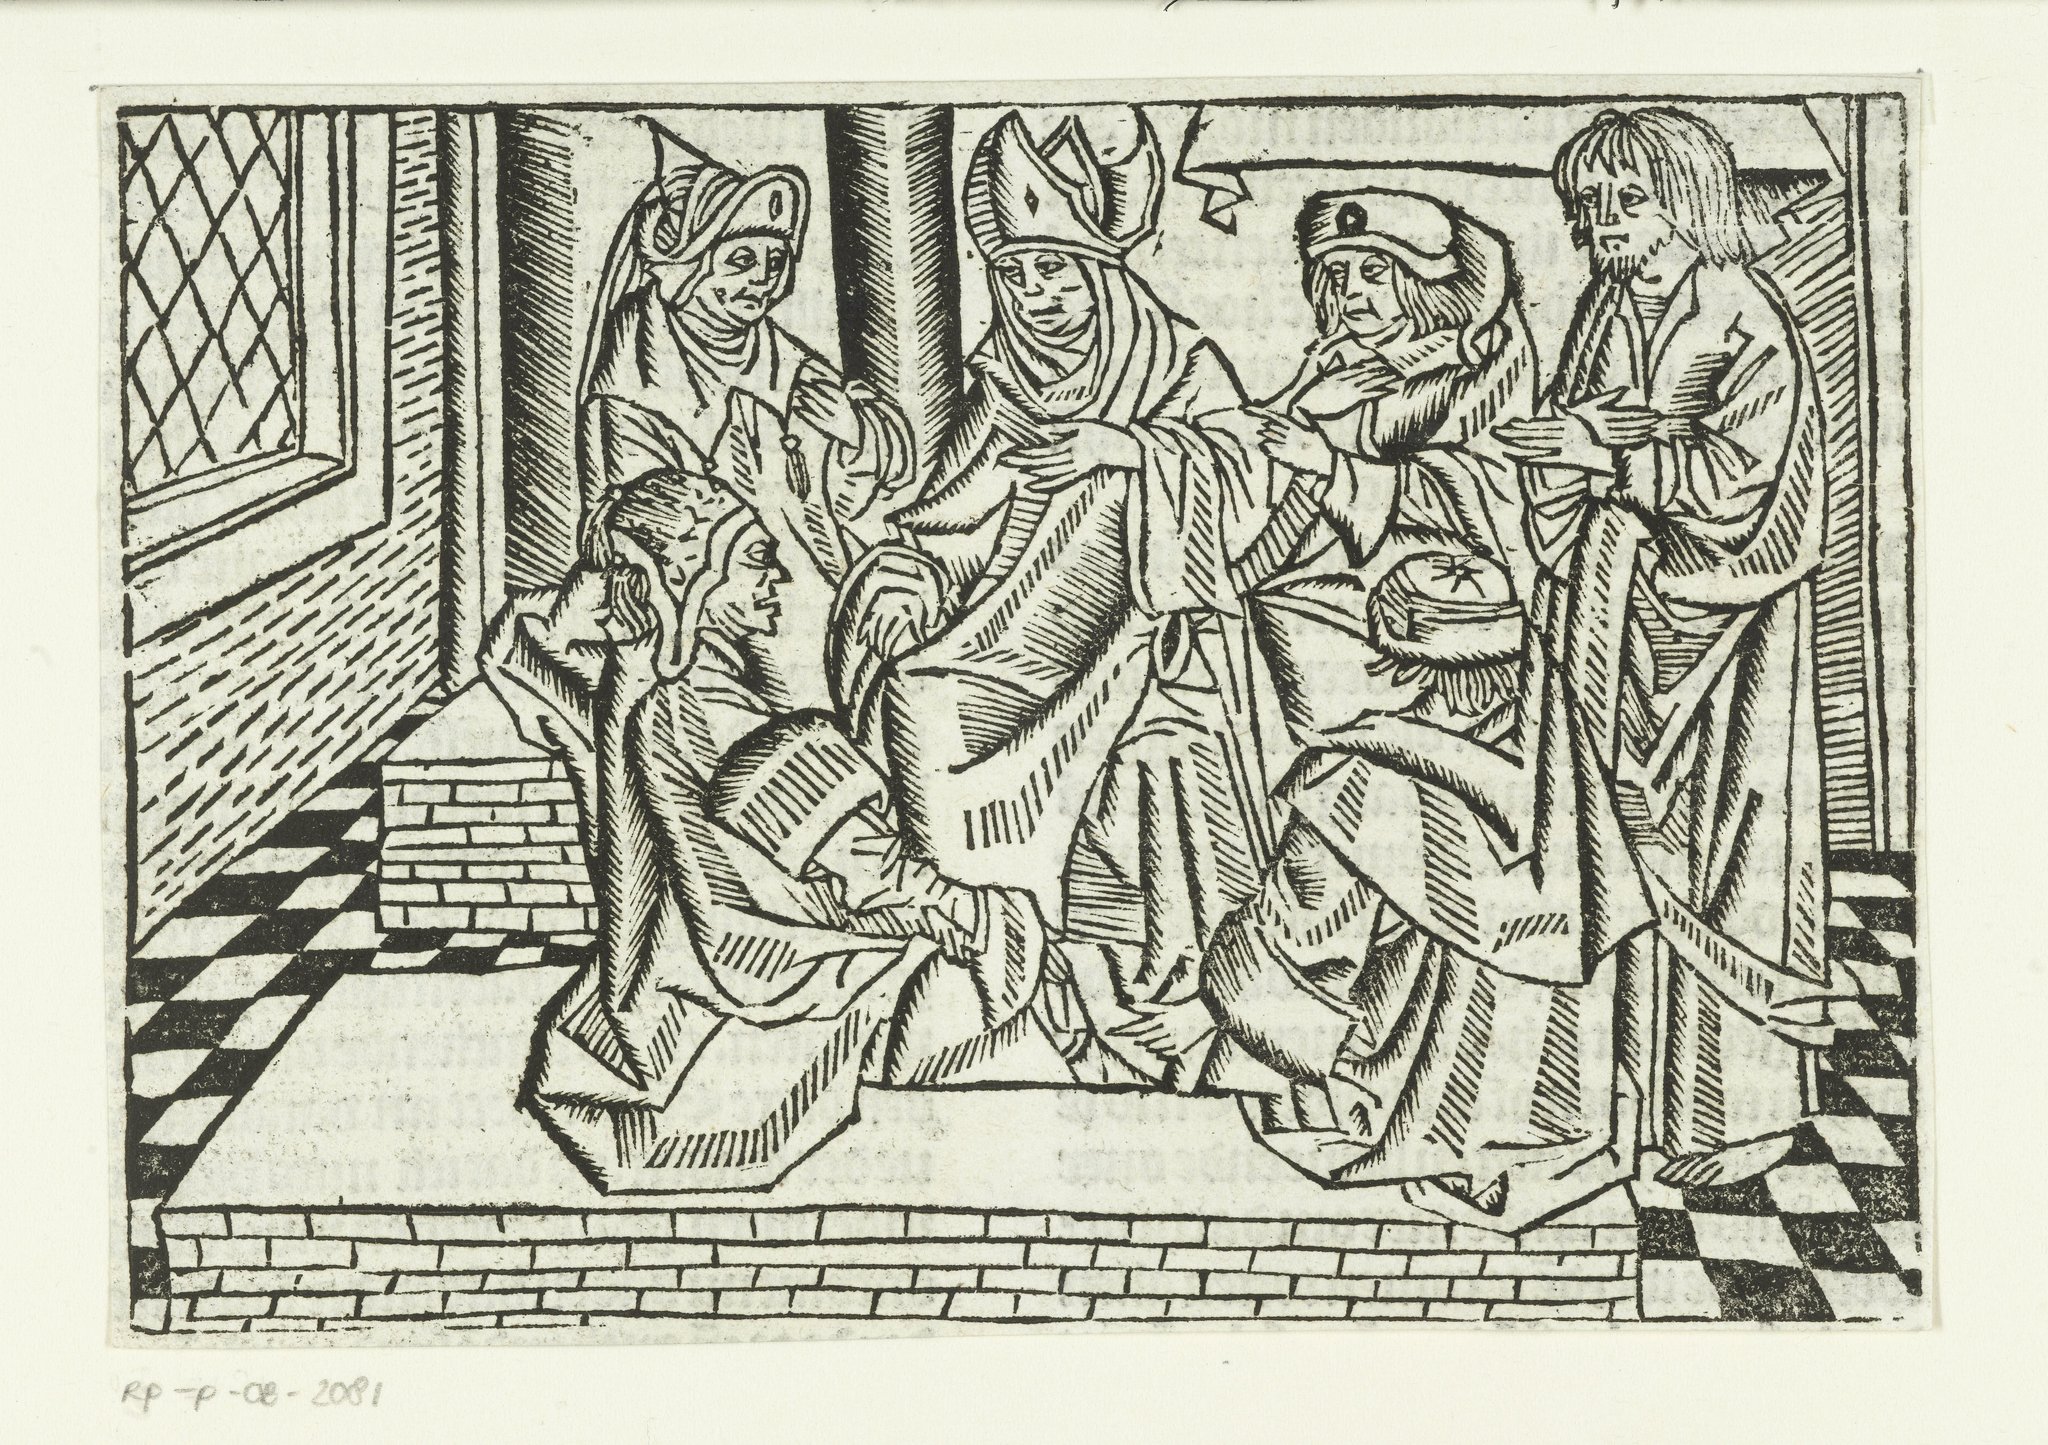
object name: book illustration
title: Judas bij de hogepriesters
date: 1480-1500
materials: paper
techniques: woodcut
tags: judas goes out to the chief priests, betrays christ and receives the reward (matthew 26:14-16; mark 14:10-11; luke 22:4-6)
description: Eén blad van 113 uit Ludolphus de Saxonia, "Dit es dleué ons liefs heeren ihesu christi". Anonieme Nederlandse vertaling. Uitgegeven door Henrick Eckert van Homberch te Antwerpen in 1503. Botke, K. Deze 113 houtsneden, die meestal reeds in vroege Nederlandse boeken gebruikt zijn, worden toegeschreven aan de tweede Meester van Delft, de Meester van de Delbecq-Schreiber-passie en de Meester van de Virgo inter Virgines. In Conway (1884) en in "De gulden passer"(1951) zijn ook eerdere versies opgenomen. Botke, K.